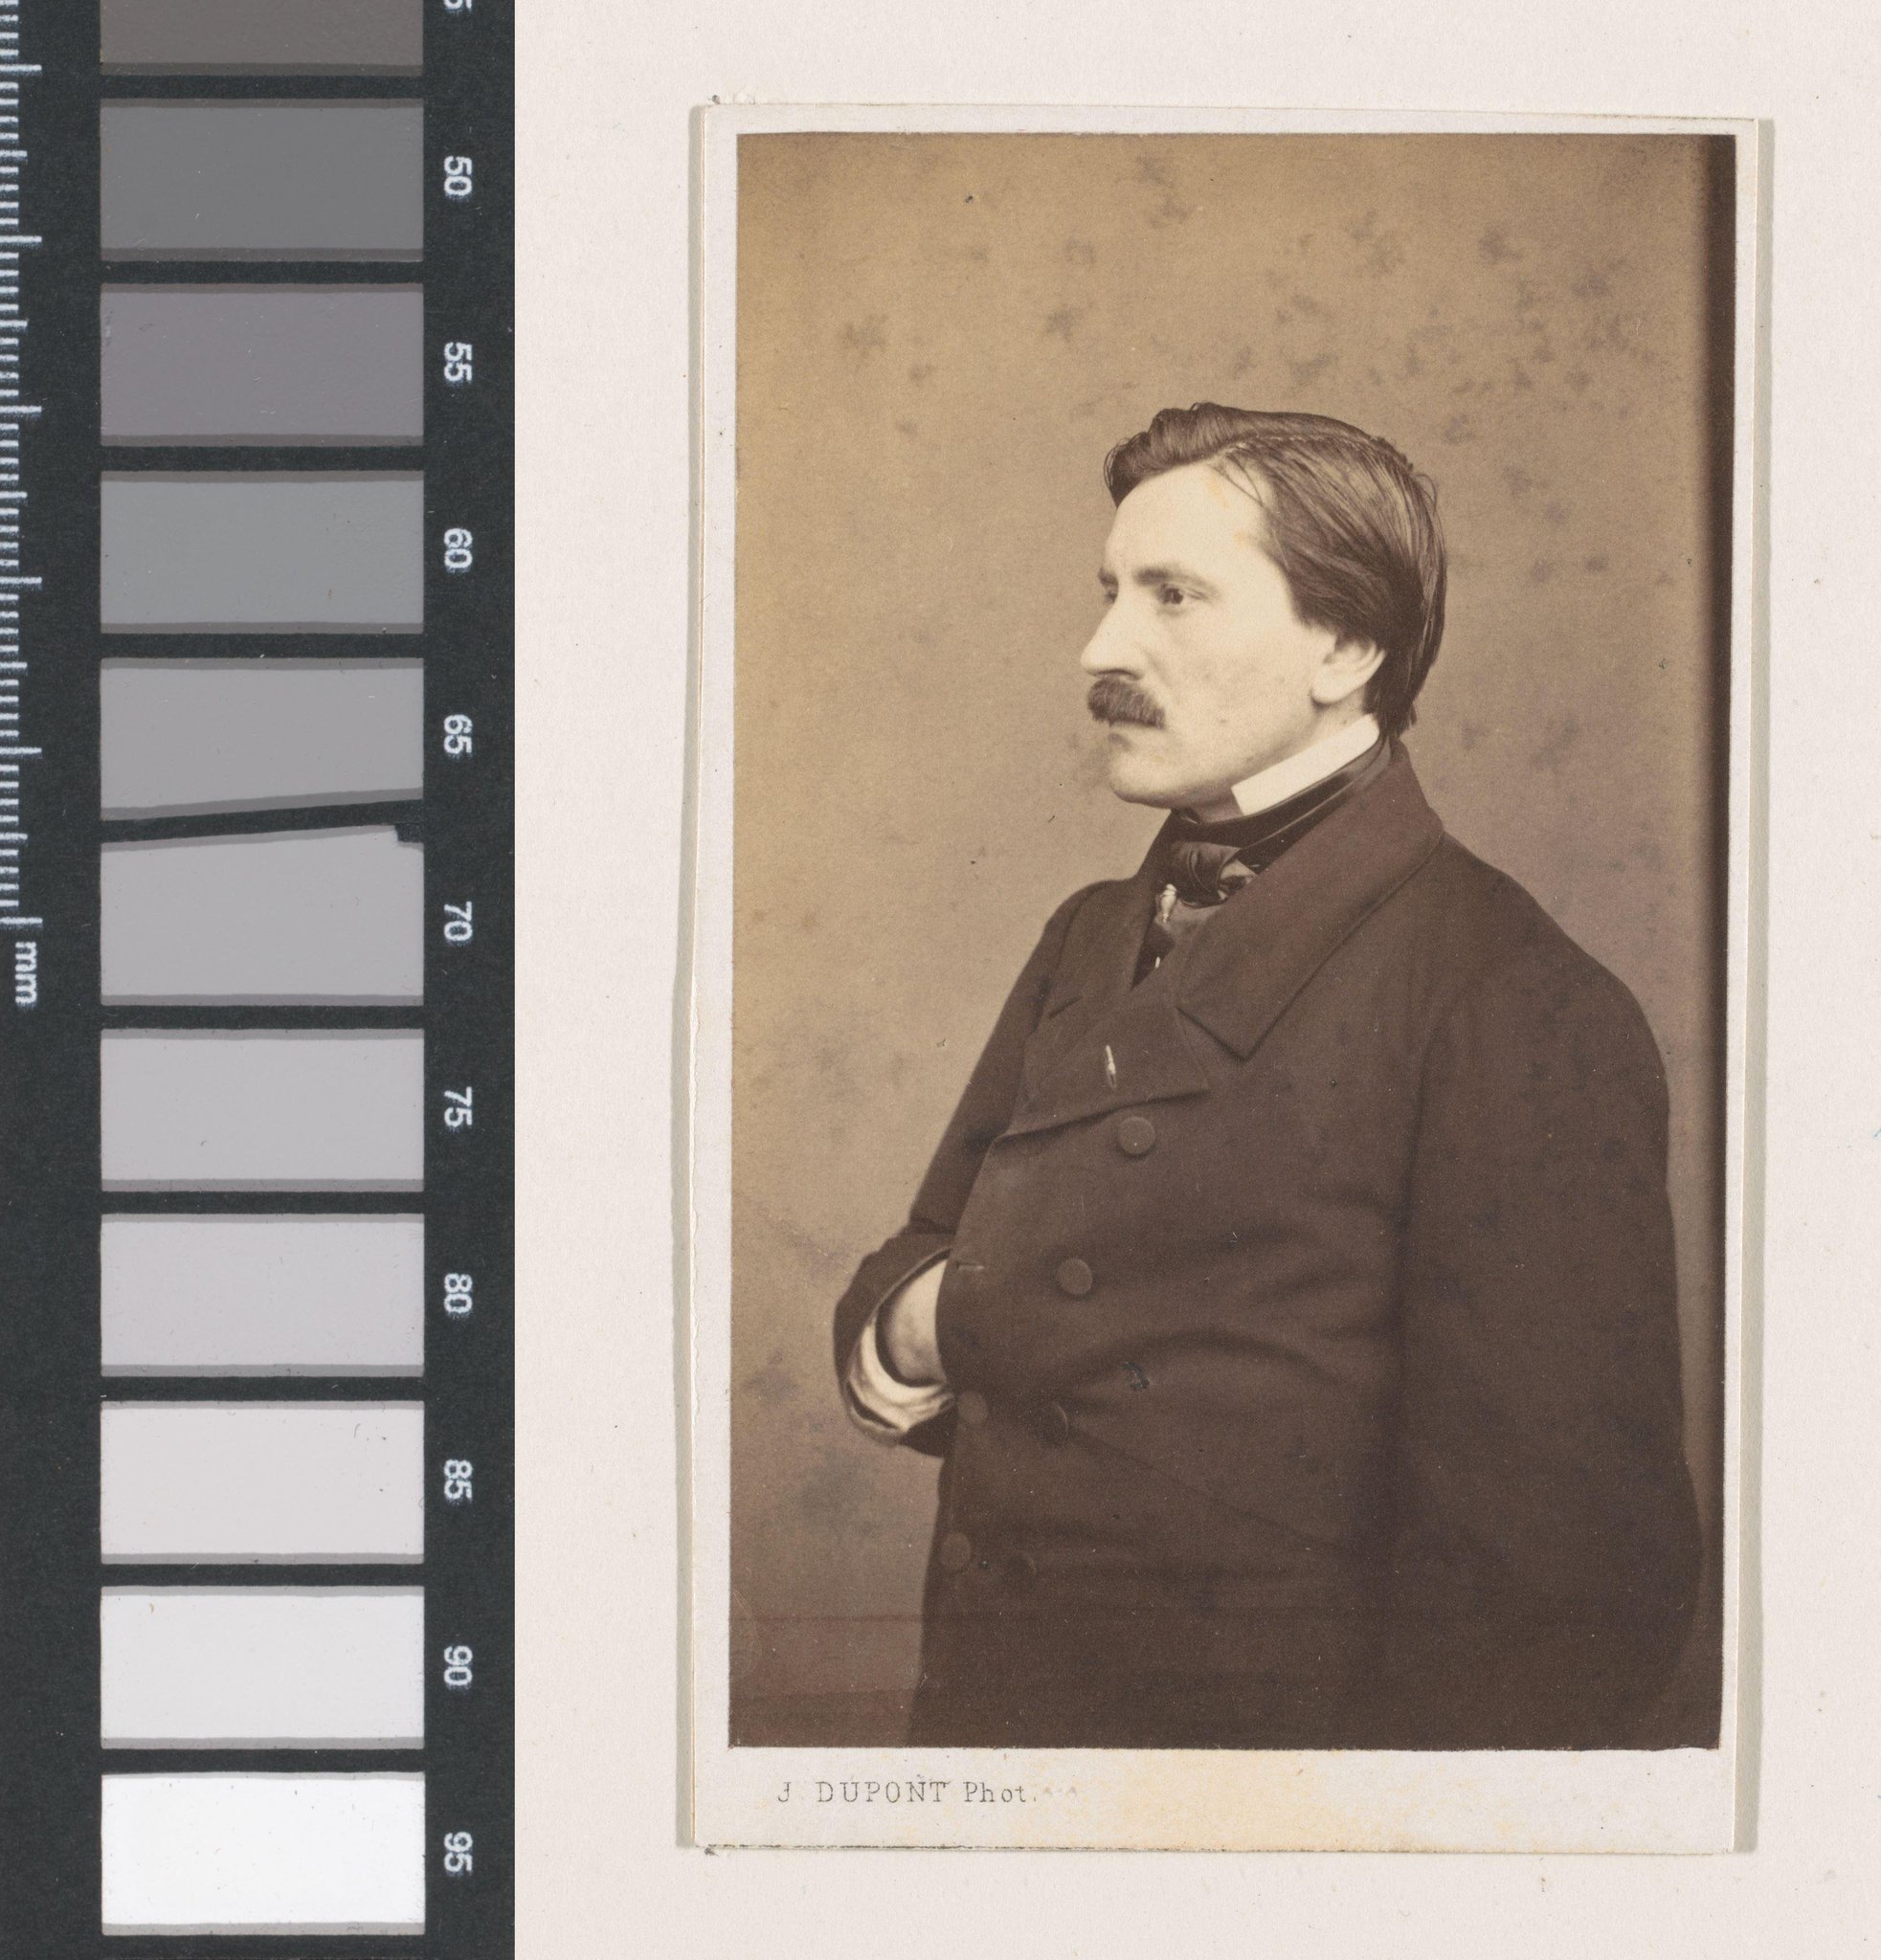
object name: photograph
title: L'École d'Anvers. Portraits biographies cartes de visite. Collection Dupont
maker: joseph dupont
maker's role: fotograaf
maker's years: 1818-1901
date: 1861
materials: cardboard, paper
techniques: albumen print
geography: antwerp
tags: painter, godfried guffens, historical persons, portrait, self-portrait of painter, portrait, self-portrait of artist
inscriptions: inscription: ‘ETABLISSEMENT PHOTOGRAPHIQUE/ de/ J. DUPONT/ Place de Meir 32/ ANVERS/ Maison fondée en 1853’